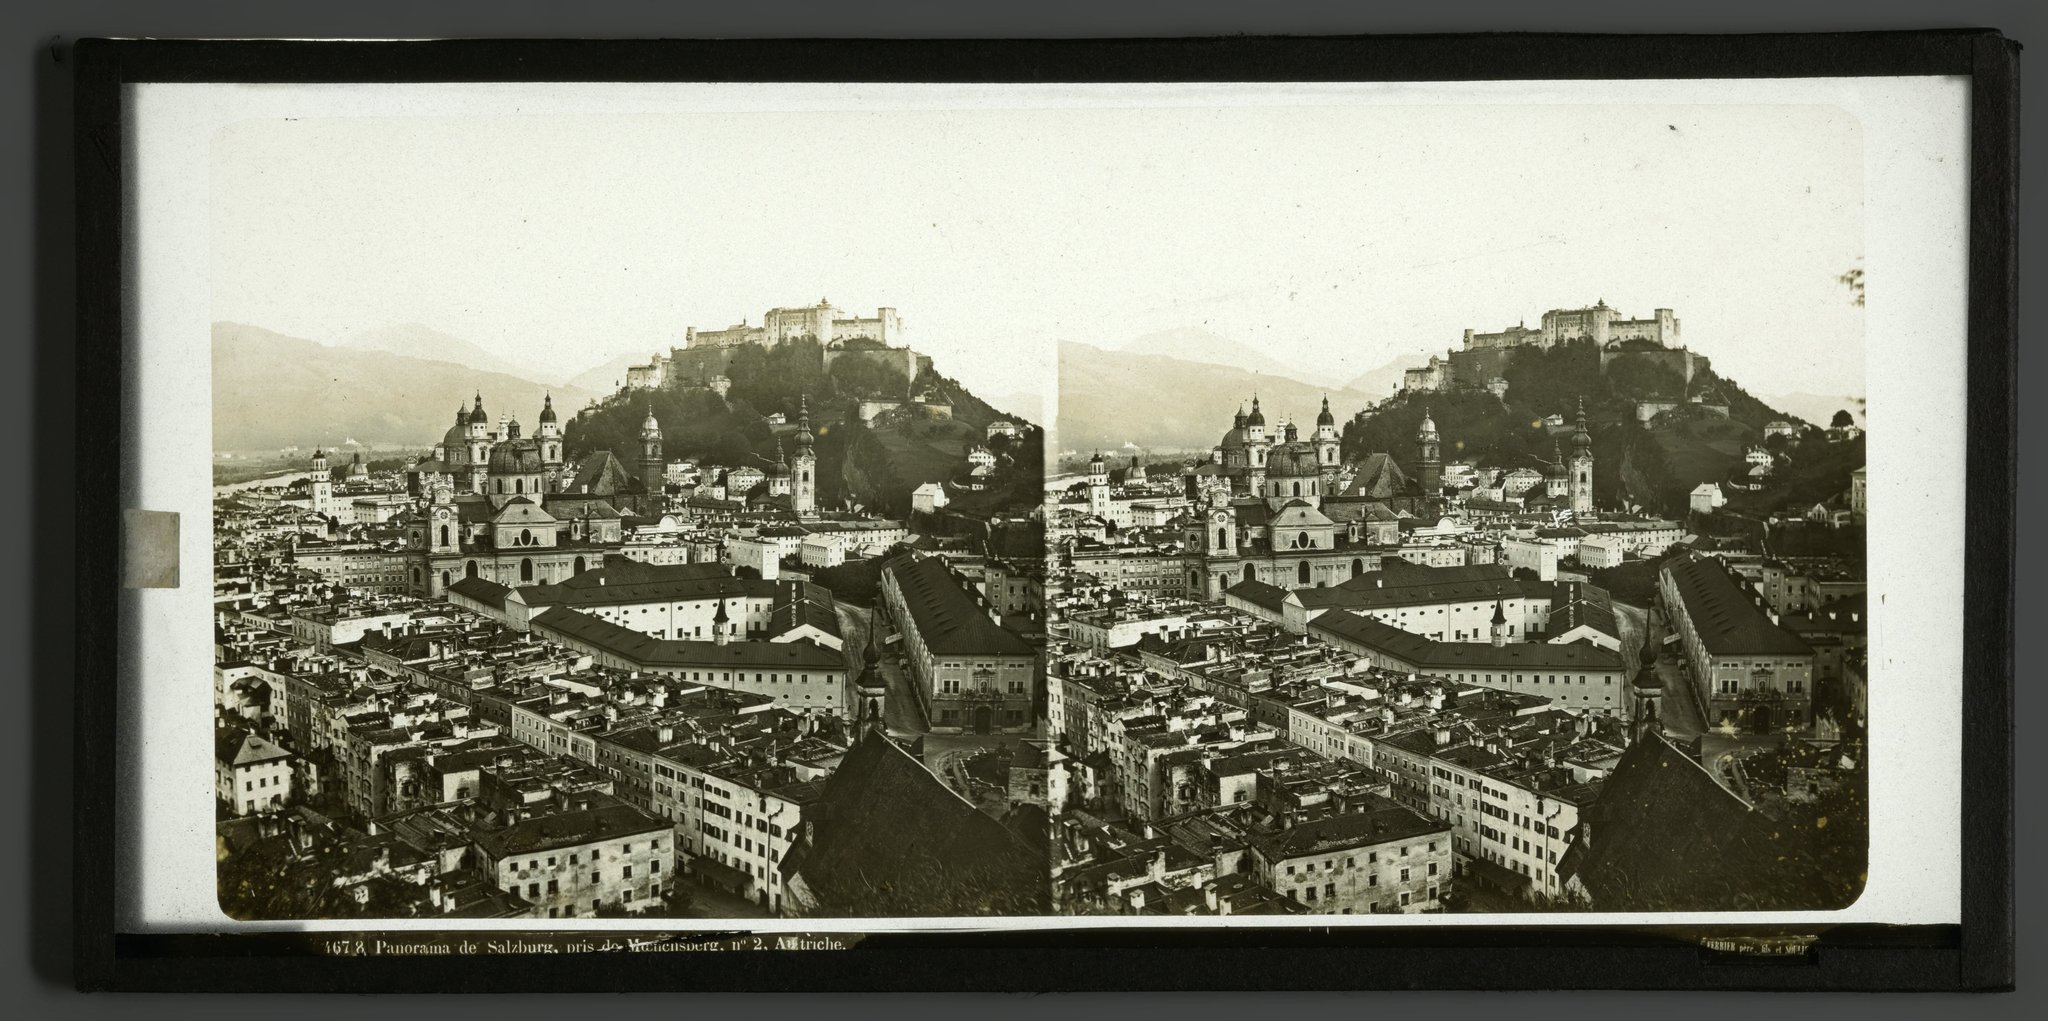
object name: stereoscopic photograph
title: Gezicht op Salzbug met de dom en Festung Hohensalzburg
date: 1860-1870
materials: glass, paper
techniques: slide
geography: salzburg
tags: city-view in general; 'veduta', castle, church (exterior)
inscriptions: inscription: ‘4678 Panorama de Salzburg, pris de Moenchsberg, no 2, Autriche’